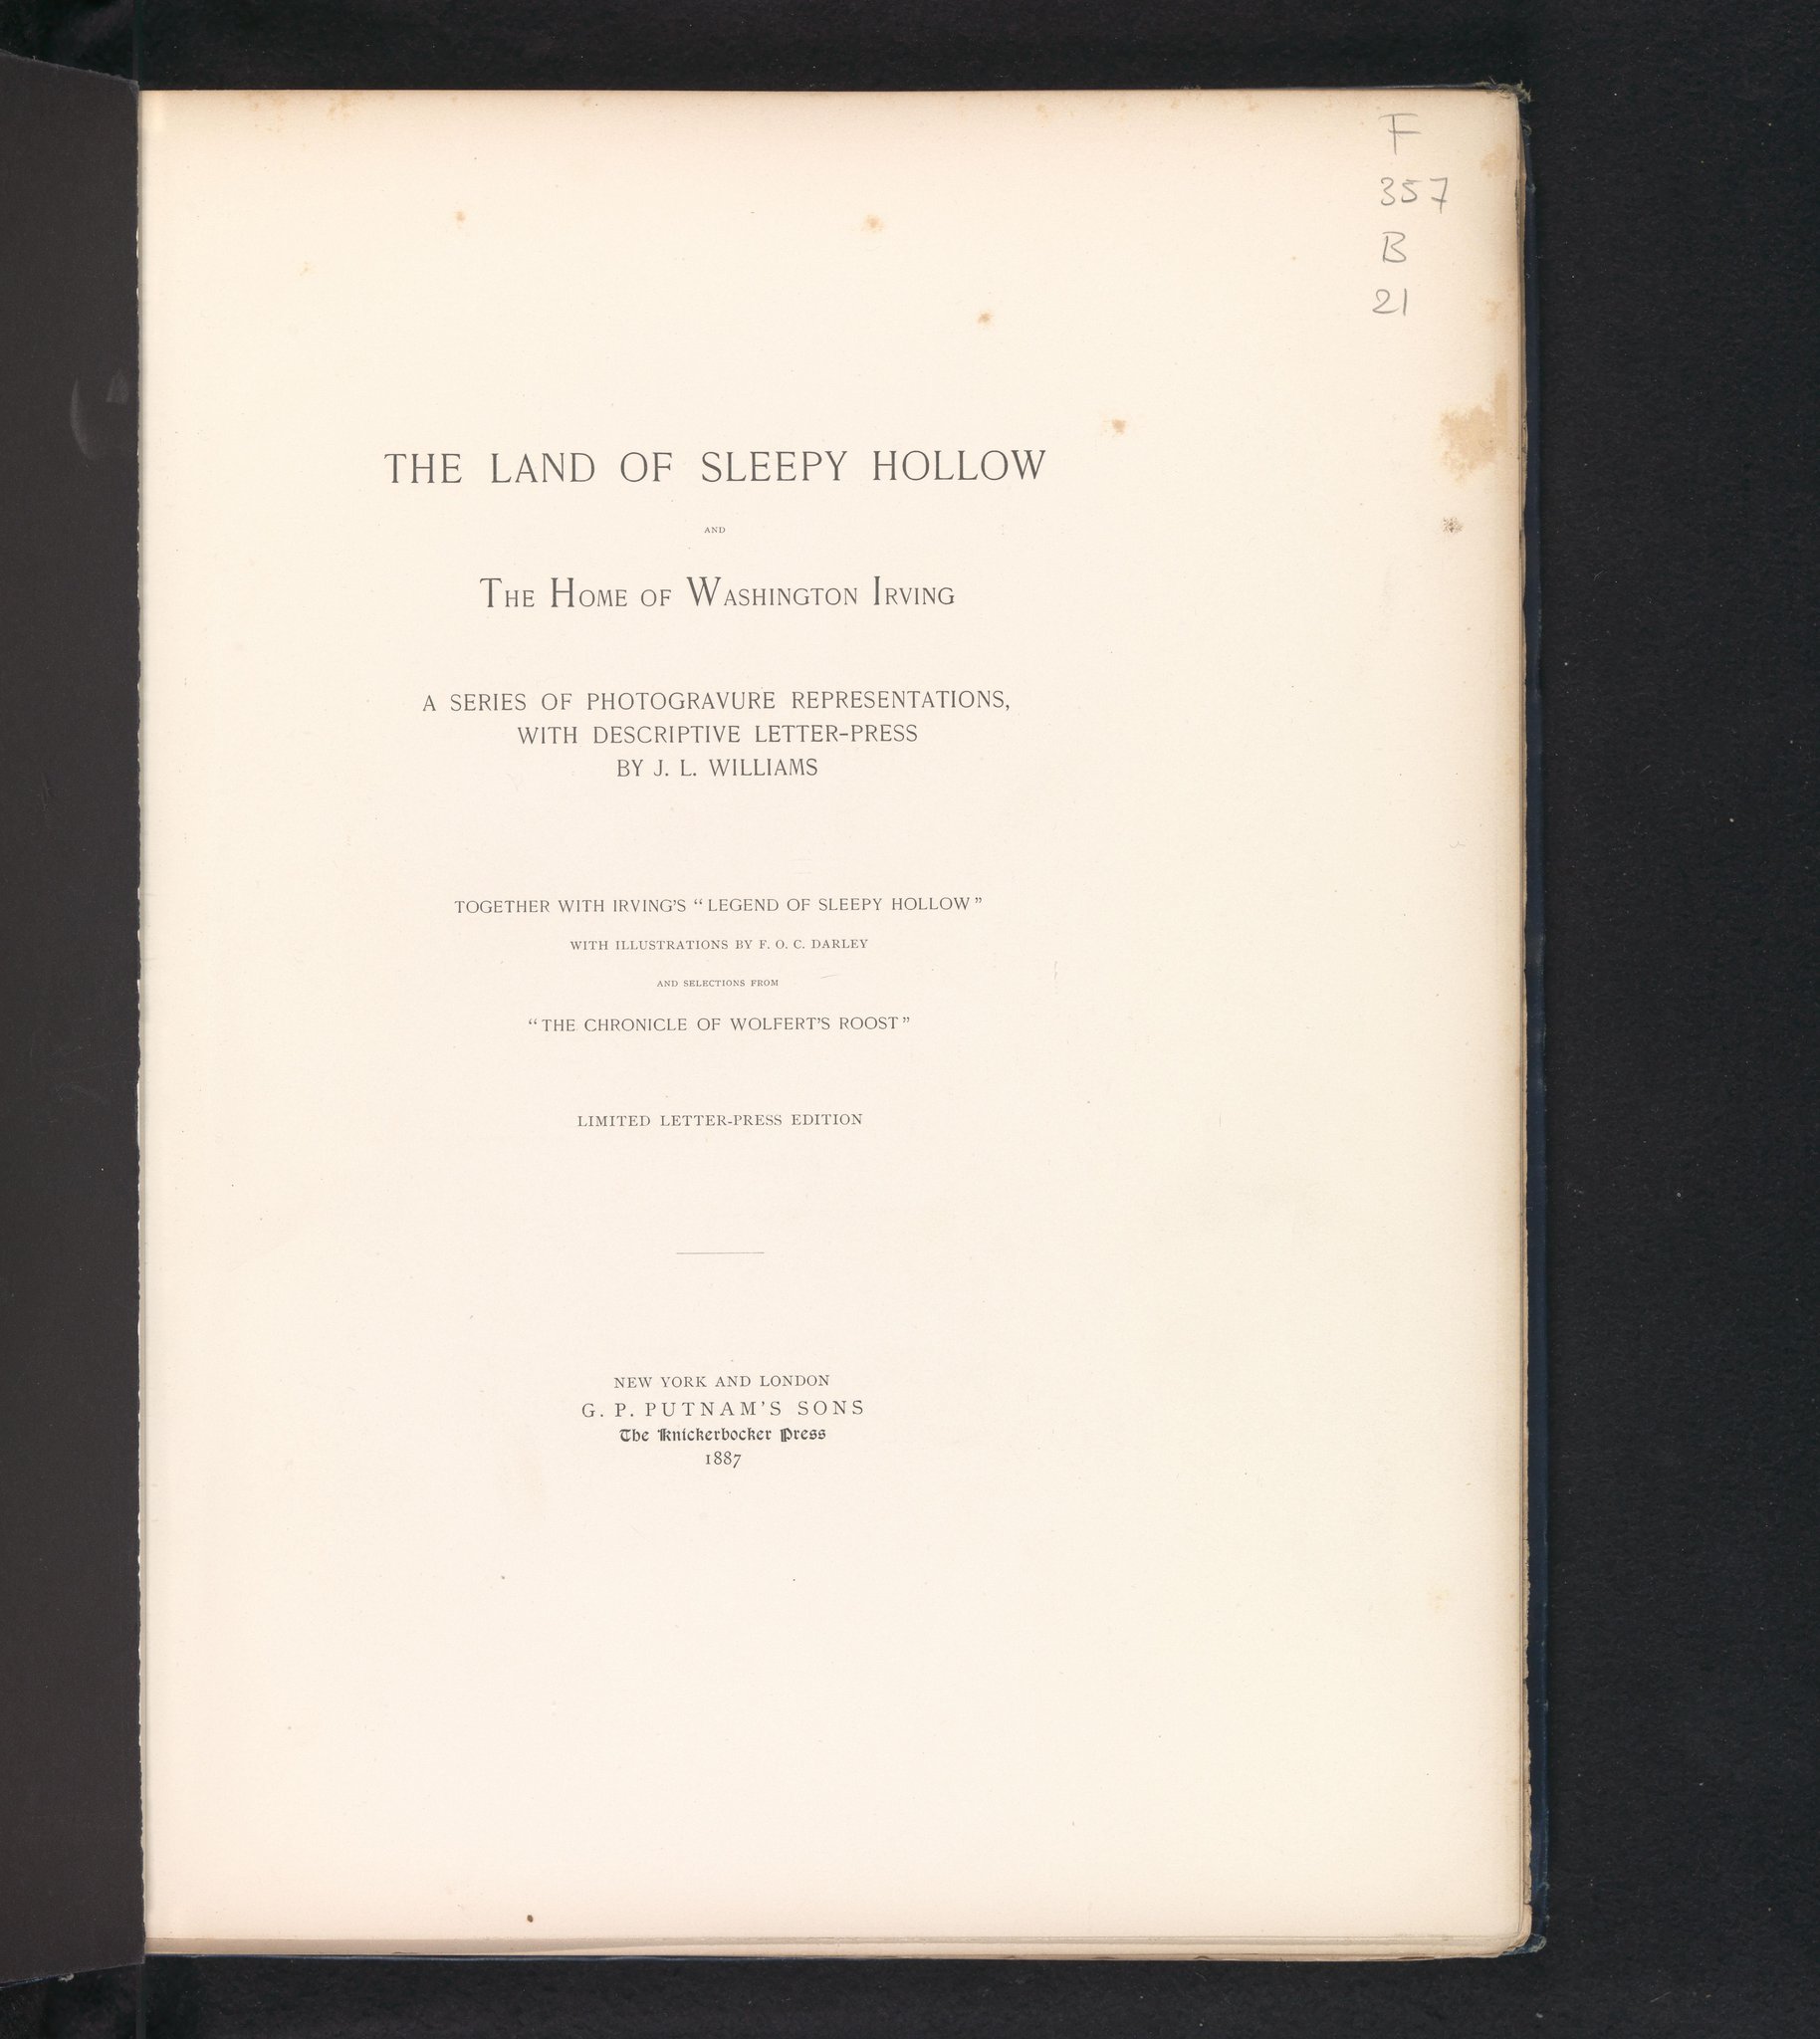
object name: book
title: The land of Sleepy Hollow and the home of Washington Irving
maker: james leon williams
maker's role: fotograaf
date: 1887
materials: cardboard, linen, paper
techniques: photoaquatint, printing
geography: new york city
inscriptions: number: ‘No. 488’